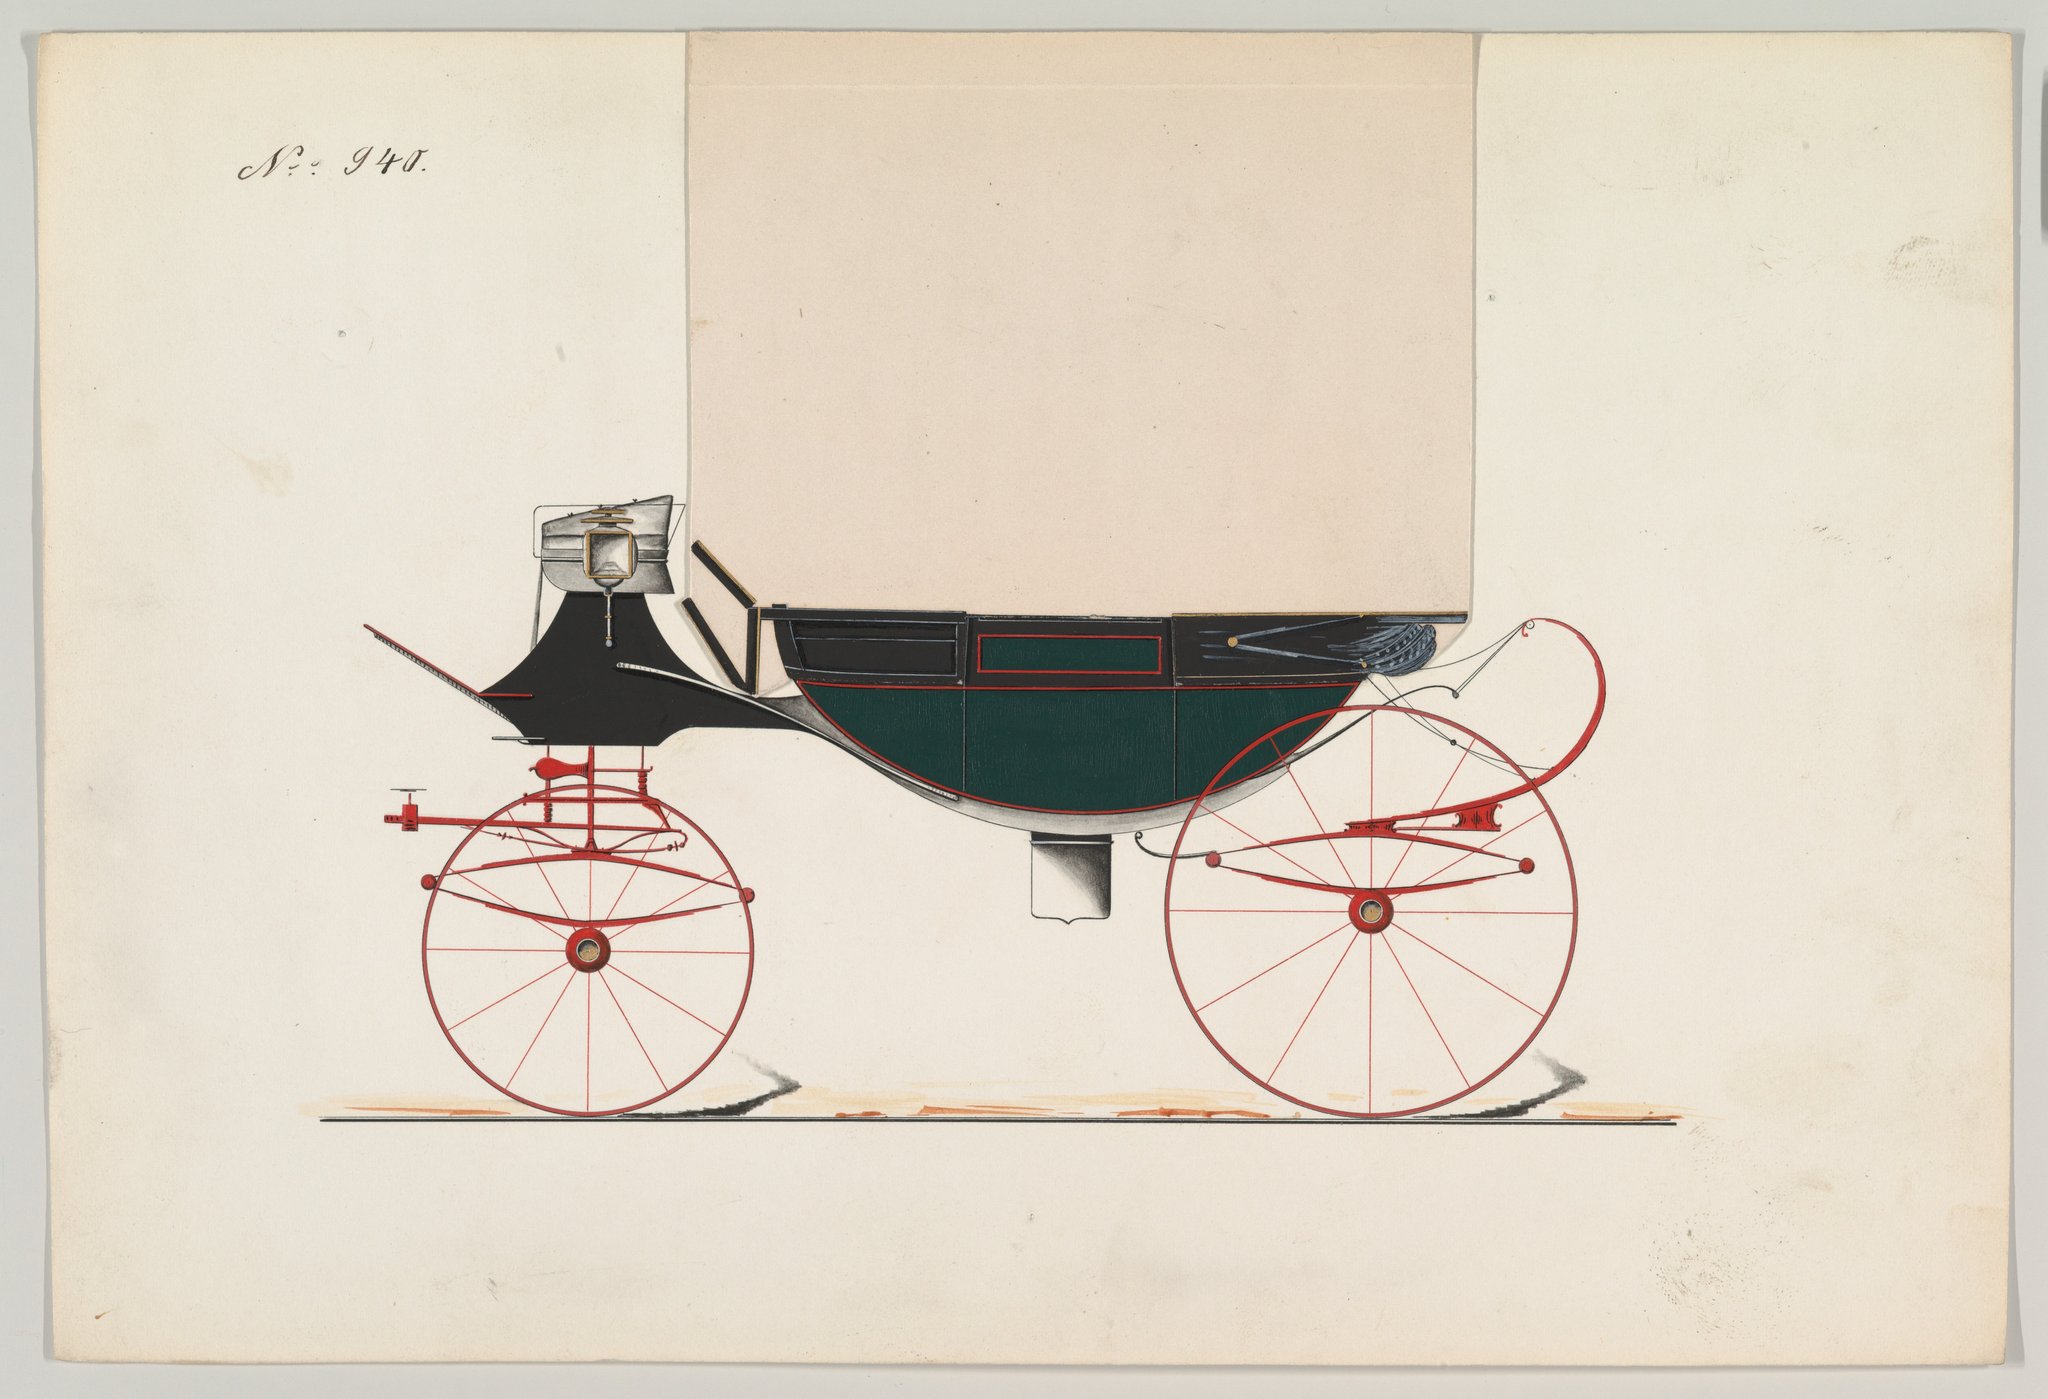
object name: drawing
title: Landau #940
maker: brewster & co.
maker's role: manufacturer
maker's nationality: american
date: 1850-1870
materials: gouache, gum arabic, ink, watercolor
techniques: pen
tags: carriages